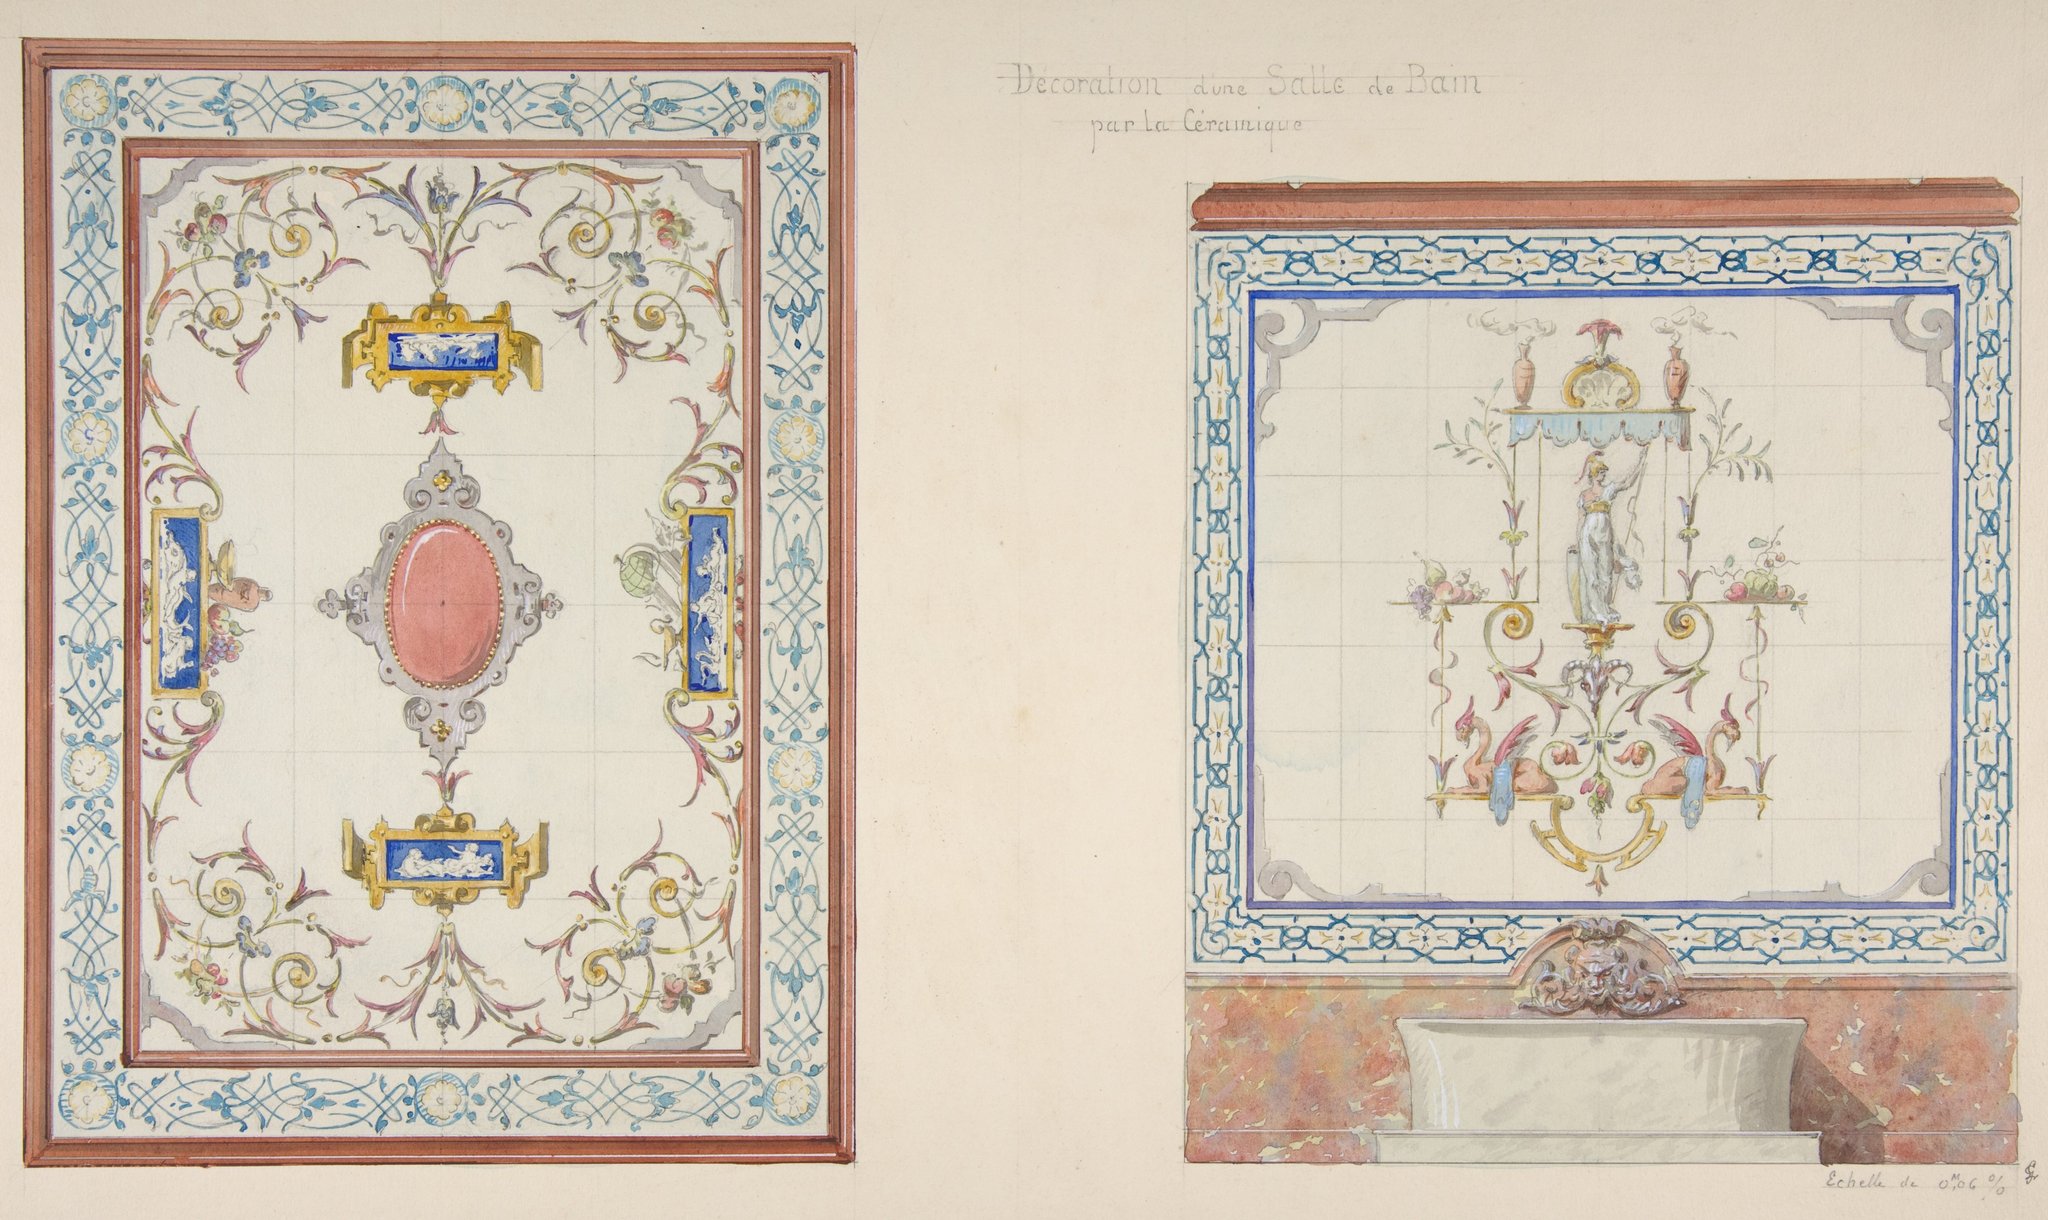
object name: drawing ornament architecture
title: Design for ceramic tile decoration of a bathroom in "Pompeian" manner (possibly for Deepdene, Dorking, Surrey)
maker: jules-edmond-charles lachaise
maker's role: artist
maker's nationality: french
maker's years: 1897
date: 1851-1900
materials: gouache, graphite, ink, watercolor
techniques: pen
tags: ceilings